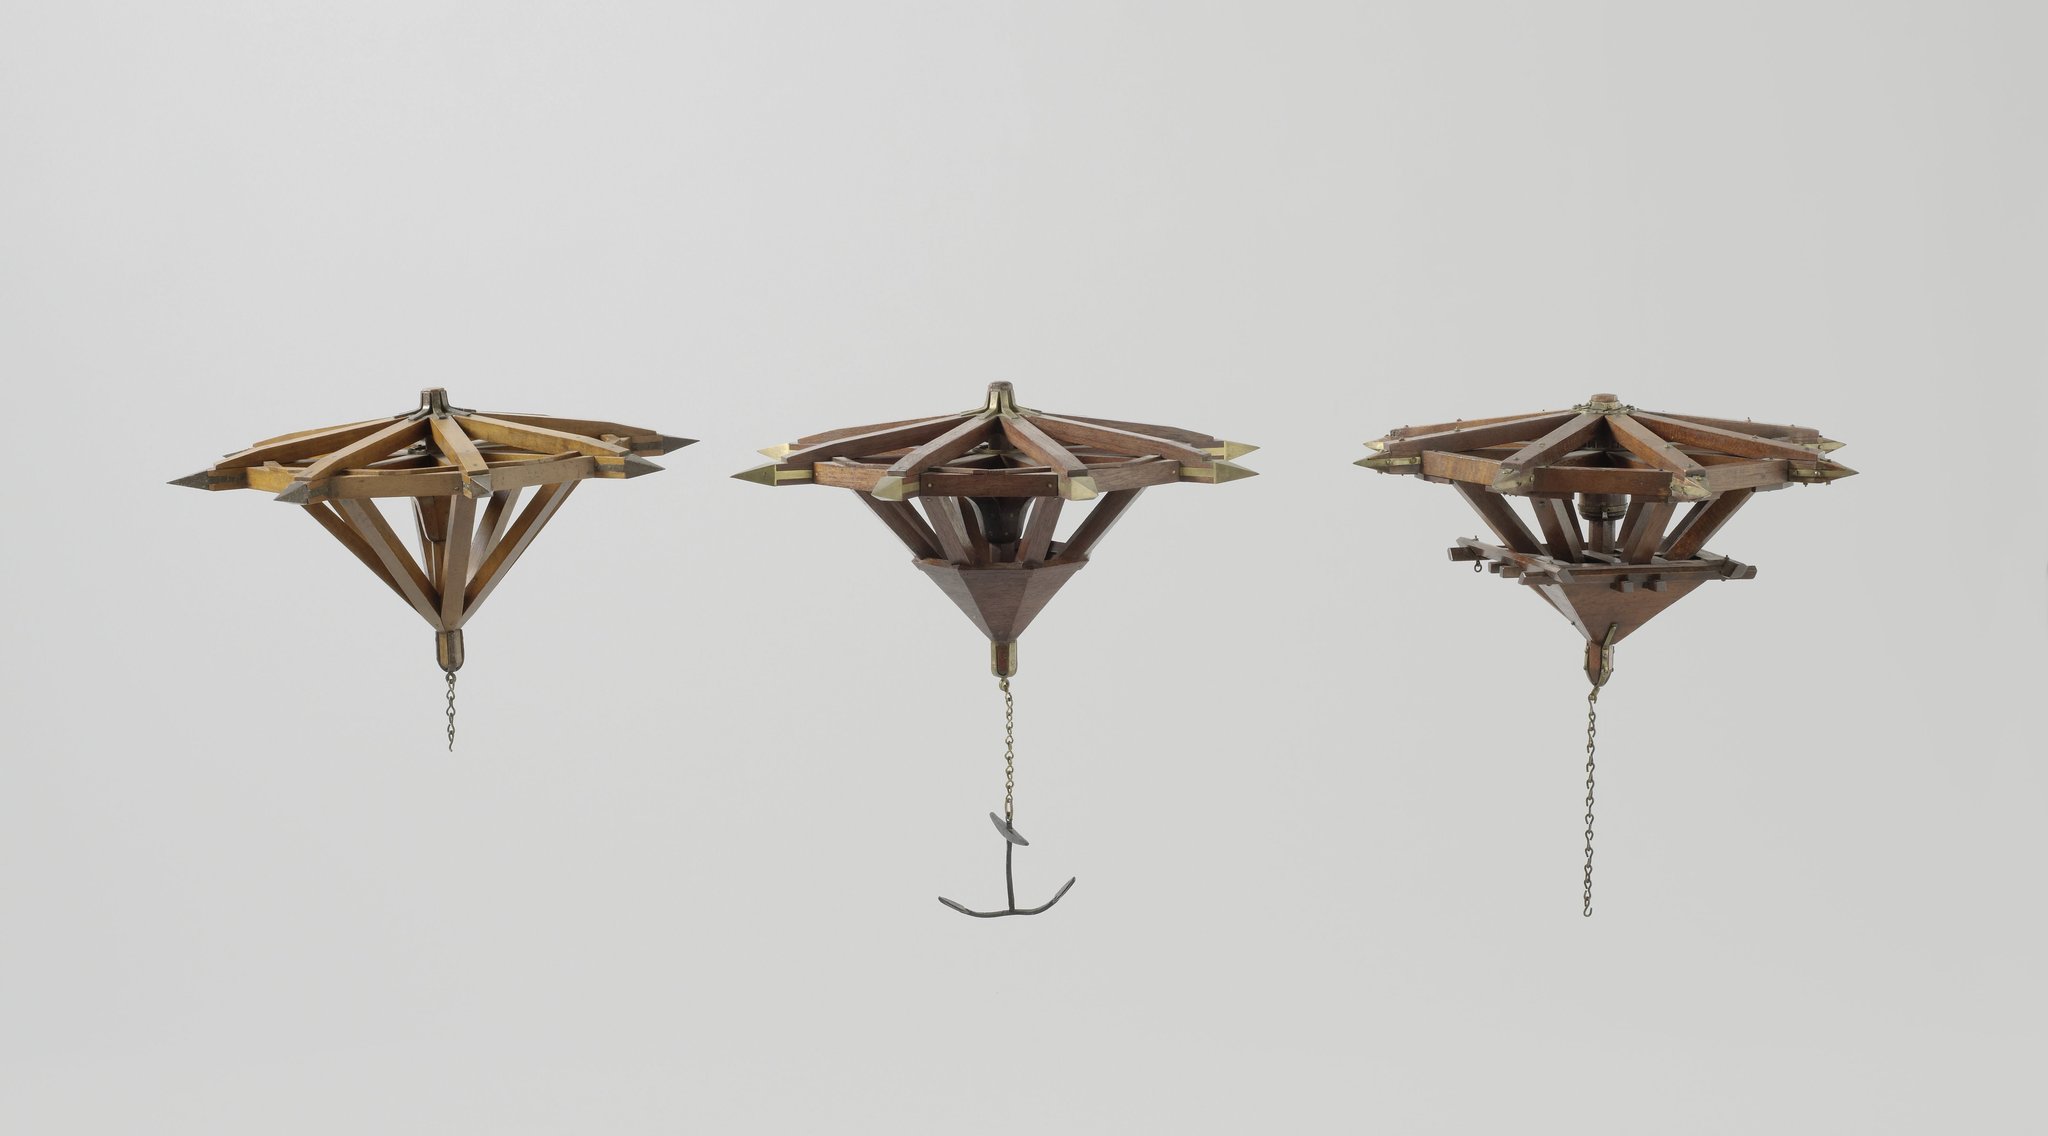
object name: demonstration model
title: Three Models of Artificial Reefs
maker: Anonymous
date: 1799-1800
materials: brass, iron, lead, wood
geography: netherlands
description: Kunstklippen of 'haspels' waren een uitvinding van H. Aeneae, lid van het Comité Central van de Marine van de Bataafse Republiek. Geankerd en net onder het wateroppervlak drijvend moesten zij de havens tegen vijandelijke schepen versperren. Een werd gebouwd en beproefd in de haven van het Nieuwediep, maar de kettingen waaraan de kanons, dienst doend als ankers, vastgemaakt waren hielden het niet en het gevaarte moest op het droge gesleept worden. Toen tijdens een storm een hospitaalschip tegen de klip aandreef, werd de klip beschadigd en niet het schip. De Zweedse admiraal Cronsaedt was geïnteresseerd in het ontwerp voor de verdediging van de Sont en de Belten en verkreeg hiervoor tekeningen en een beschrijving, evenals de Italiaanse ingenieur Salvini. .